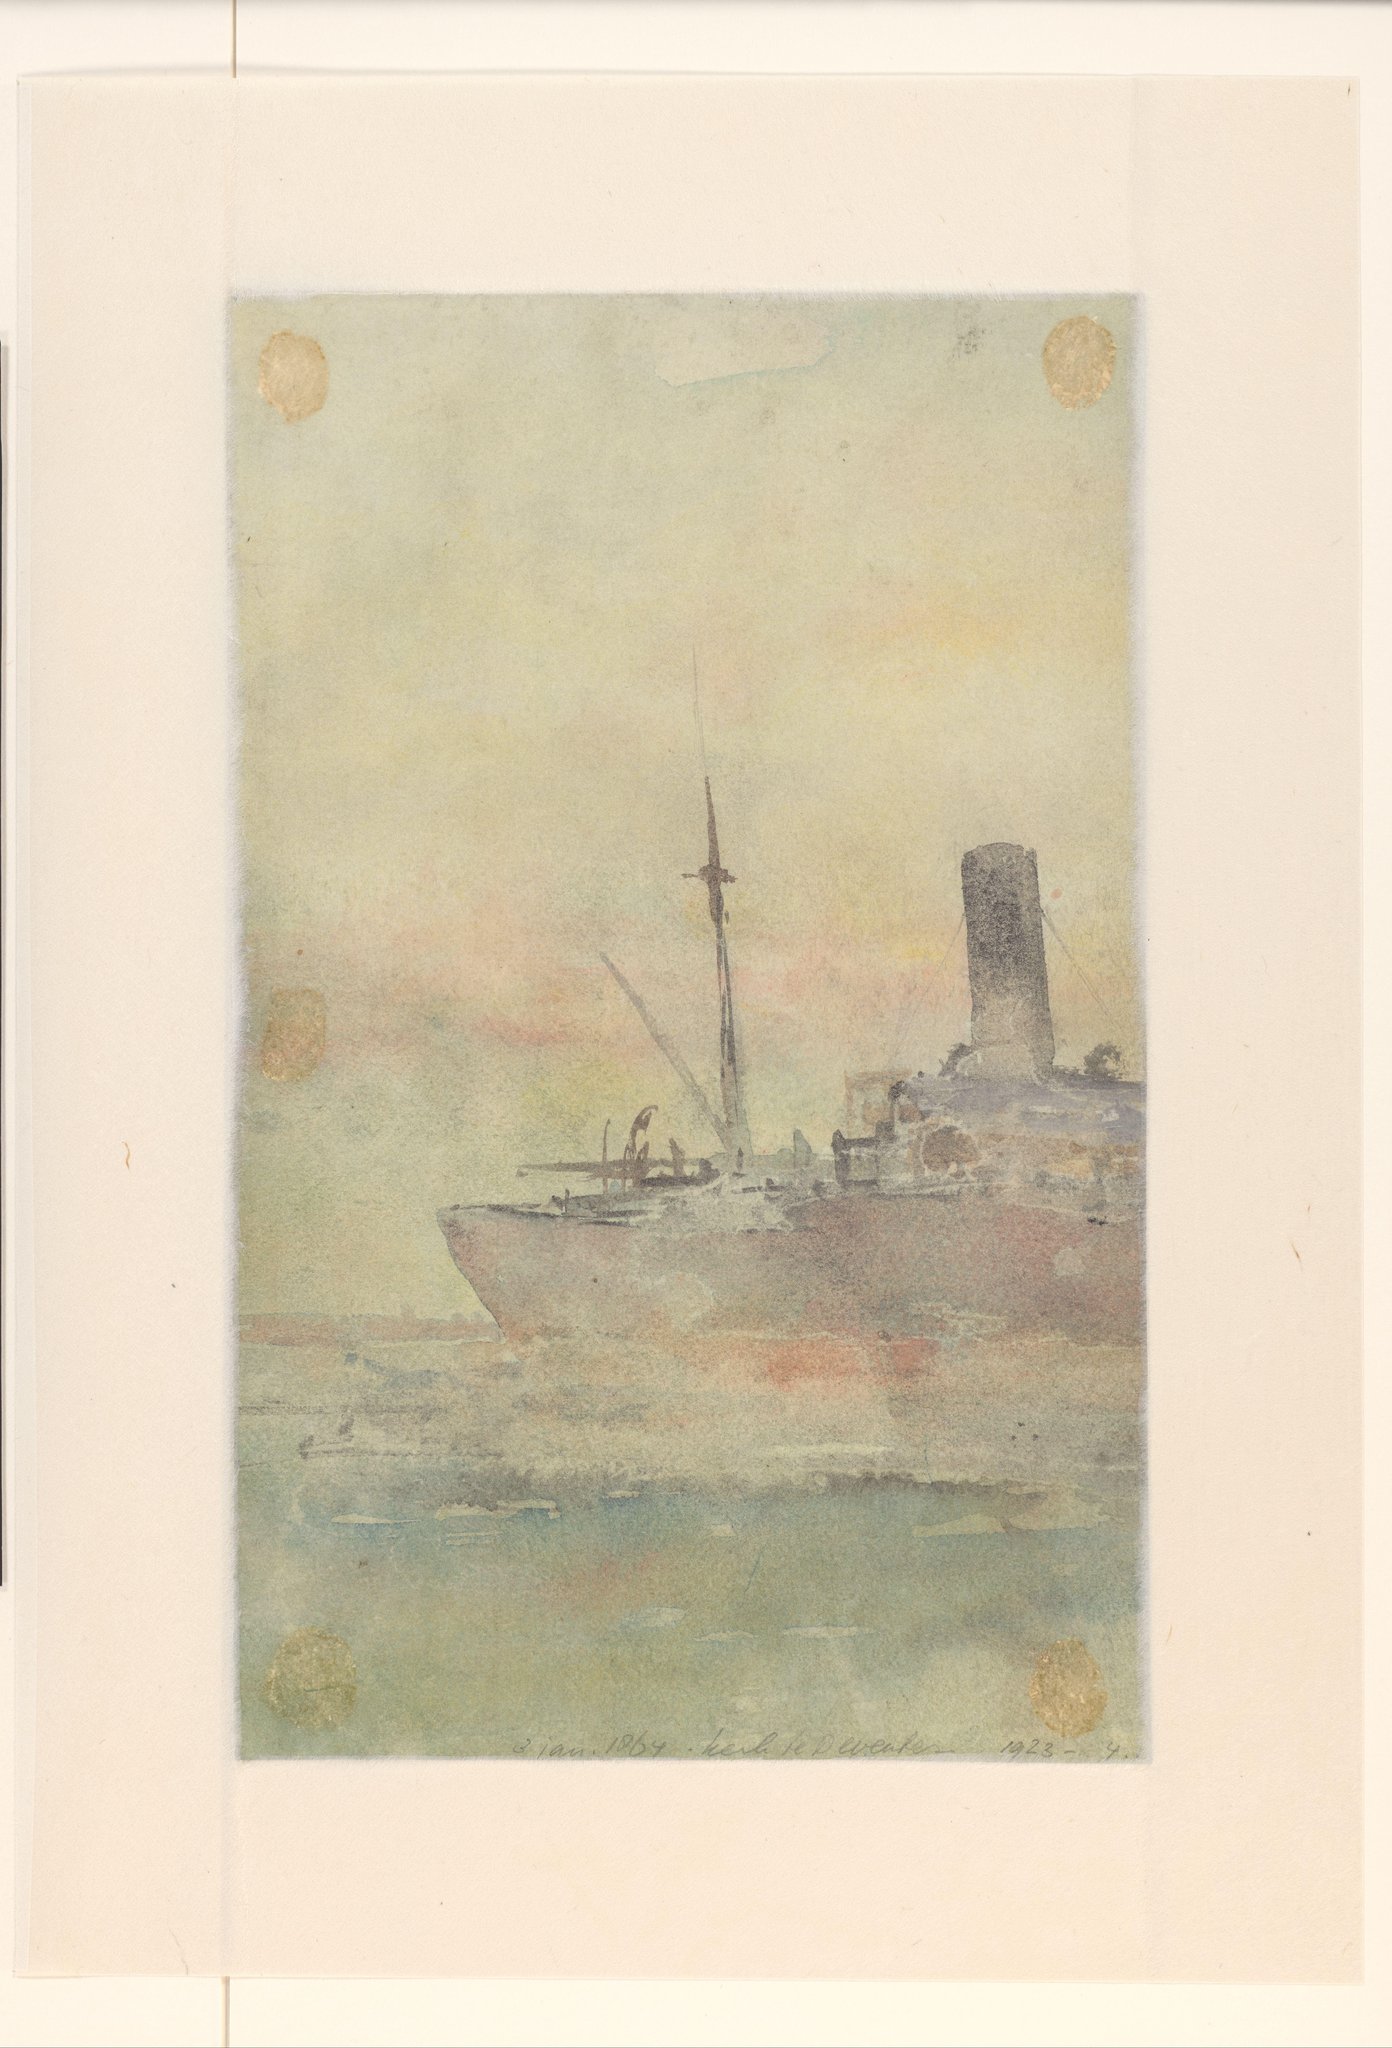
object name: drawing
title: Stoomschip (fragment)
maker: jan van der linde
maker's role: draughtsman, painter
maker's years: 1864-1945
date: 1874-1923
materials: paper, watercolor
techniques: brush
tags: steamship, motorship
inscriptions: inscription: ‘3 jan. 1864. kerk te Deventer’